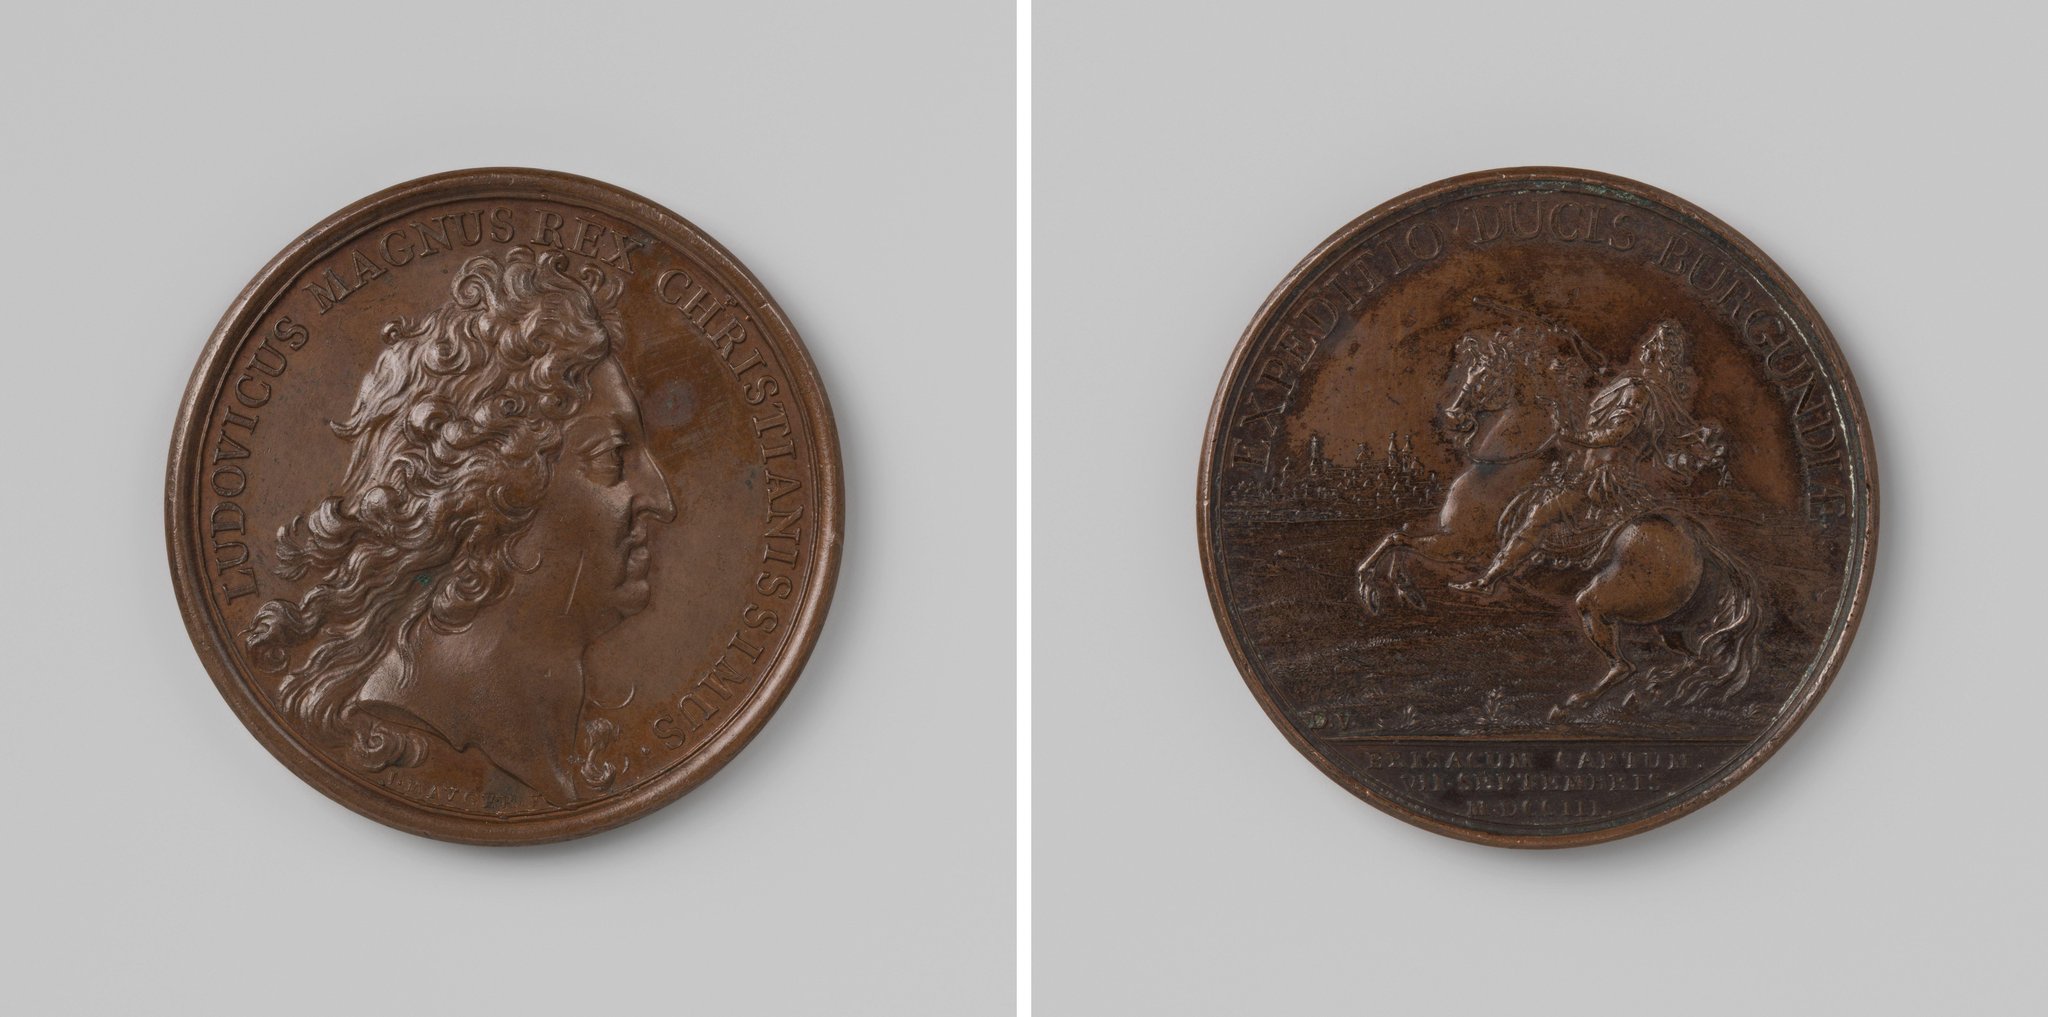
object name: history medal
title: Breisach ingenomen door de hertog van Bourgondie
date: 1716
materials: bronze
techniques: striking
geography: paris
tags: lodewijk xiv (koning van frankrijk), lodewijk van frankrijk (hertog van bourgondië)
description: Bronzen penning. Voorzijde: borststuk man binnen omschrift. Keerzijde: hertog van Bourgondie te paard met in hand commandostaf binnen omschrift, boven opschrift.